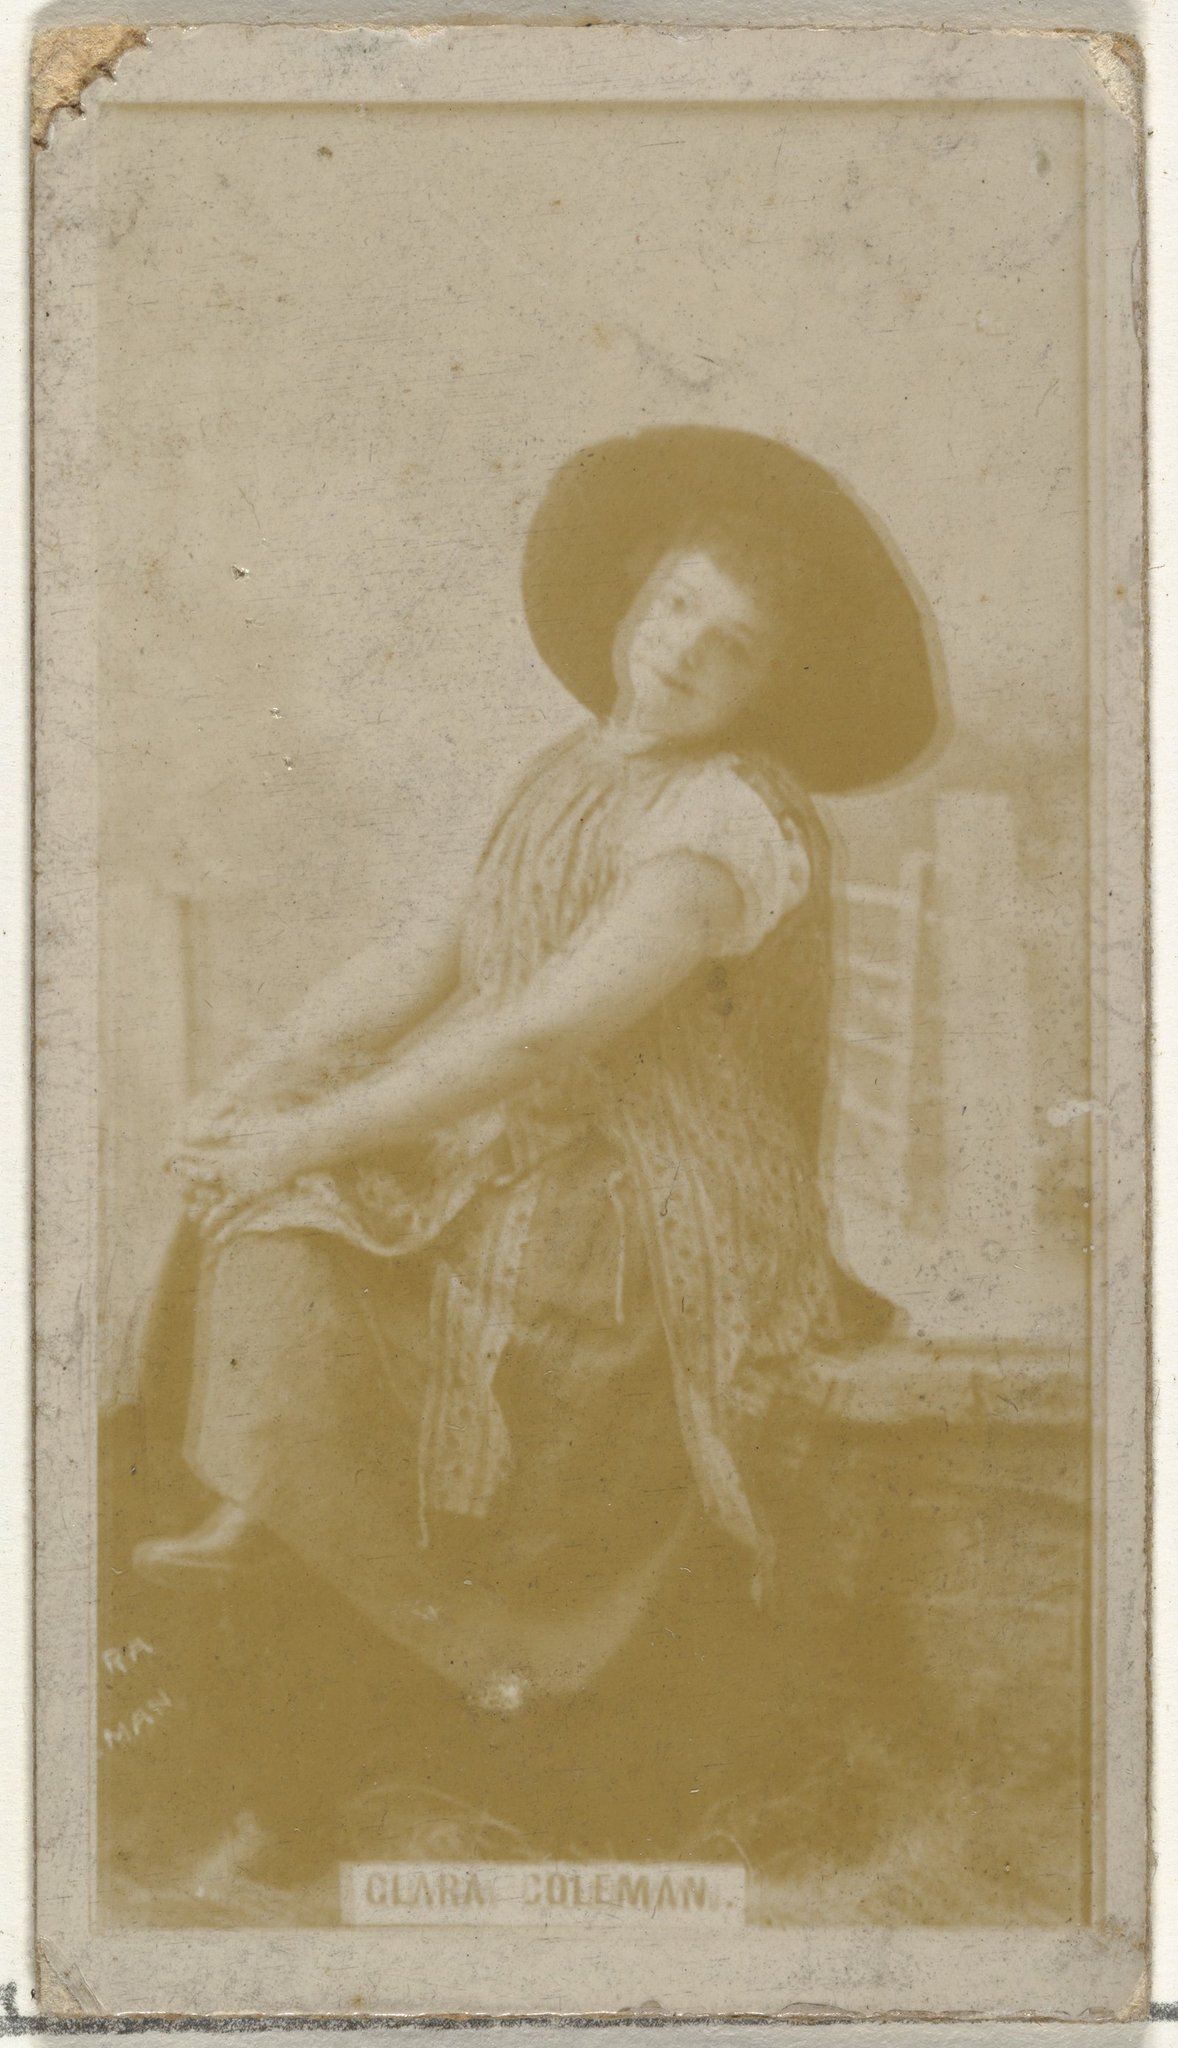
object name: photograph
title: Clara Coleman, from the Actors and Actresses series (N145-8) issued by Duke Sons & Co. to promote Duke Cigarettes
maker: w. duke, sons & co.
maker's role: publisher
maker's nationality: american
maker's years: 1870-1920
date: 1891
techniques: albumen silver print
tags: portraits,women,actresses